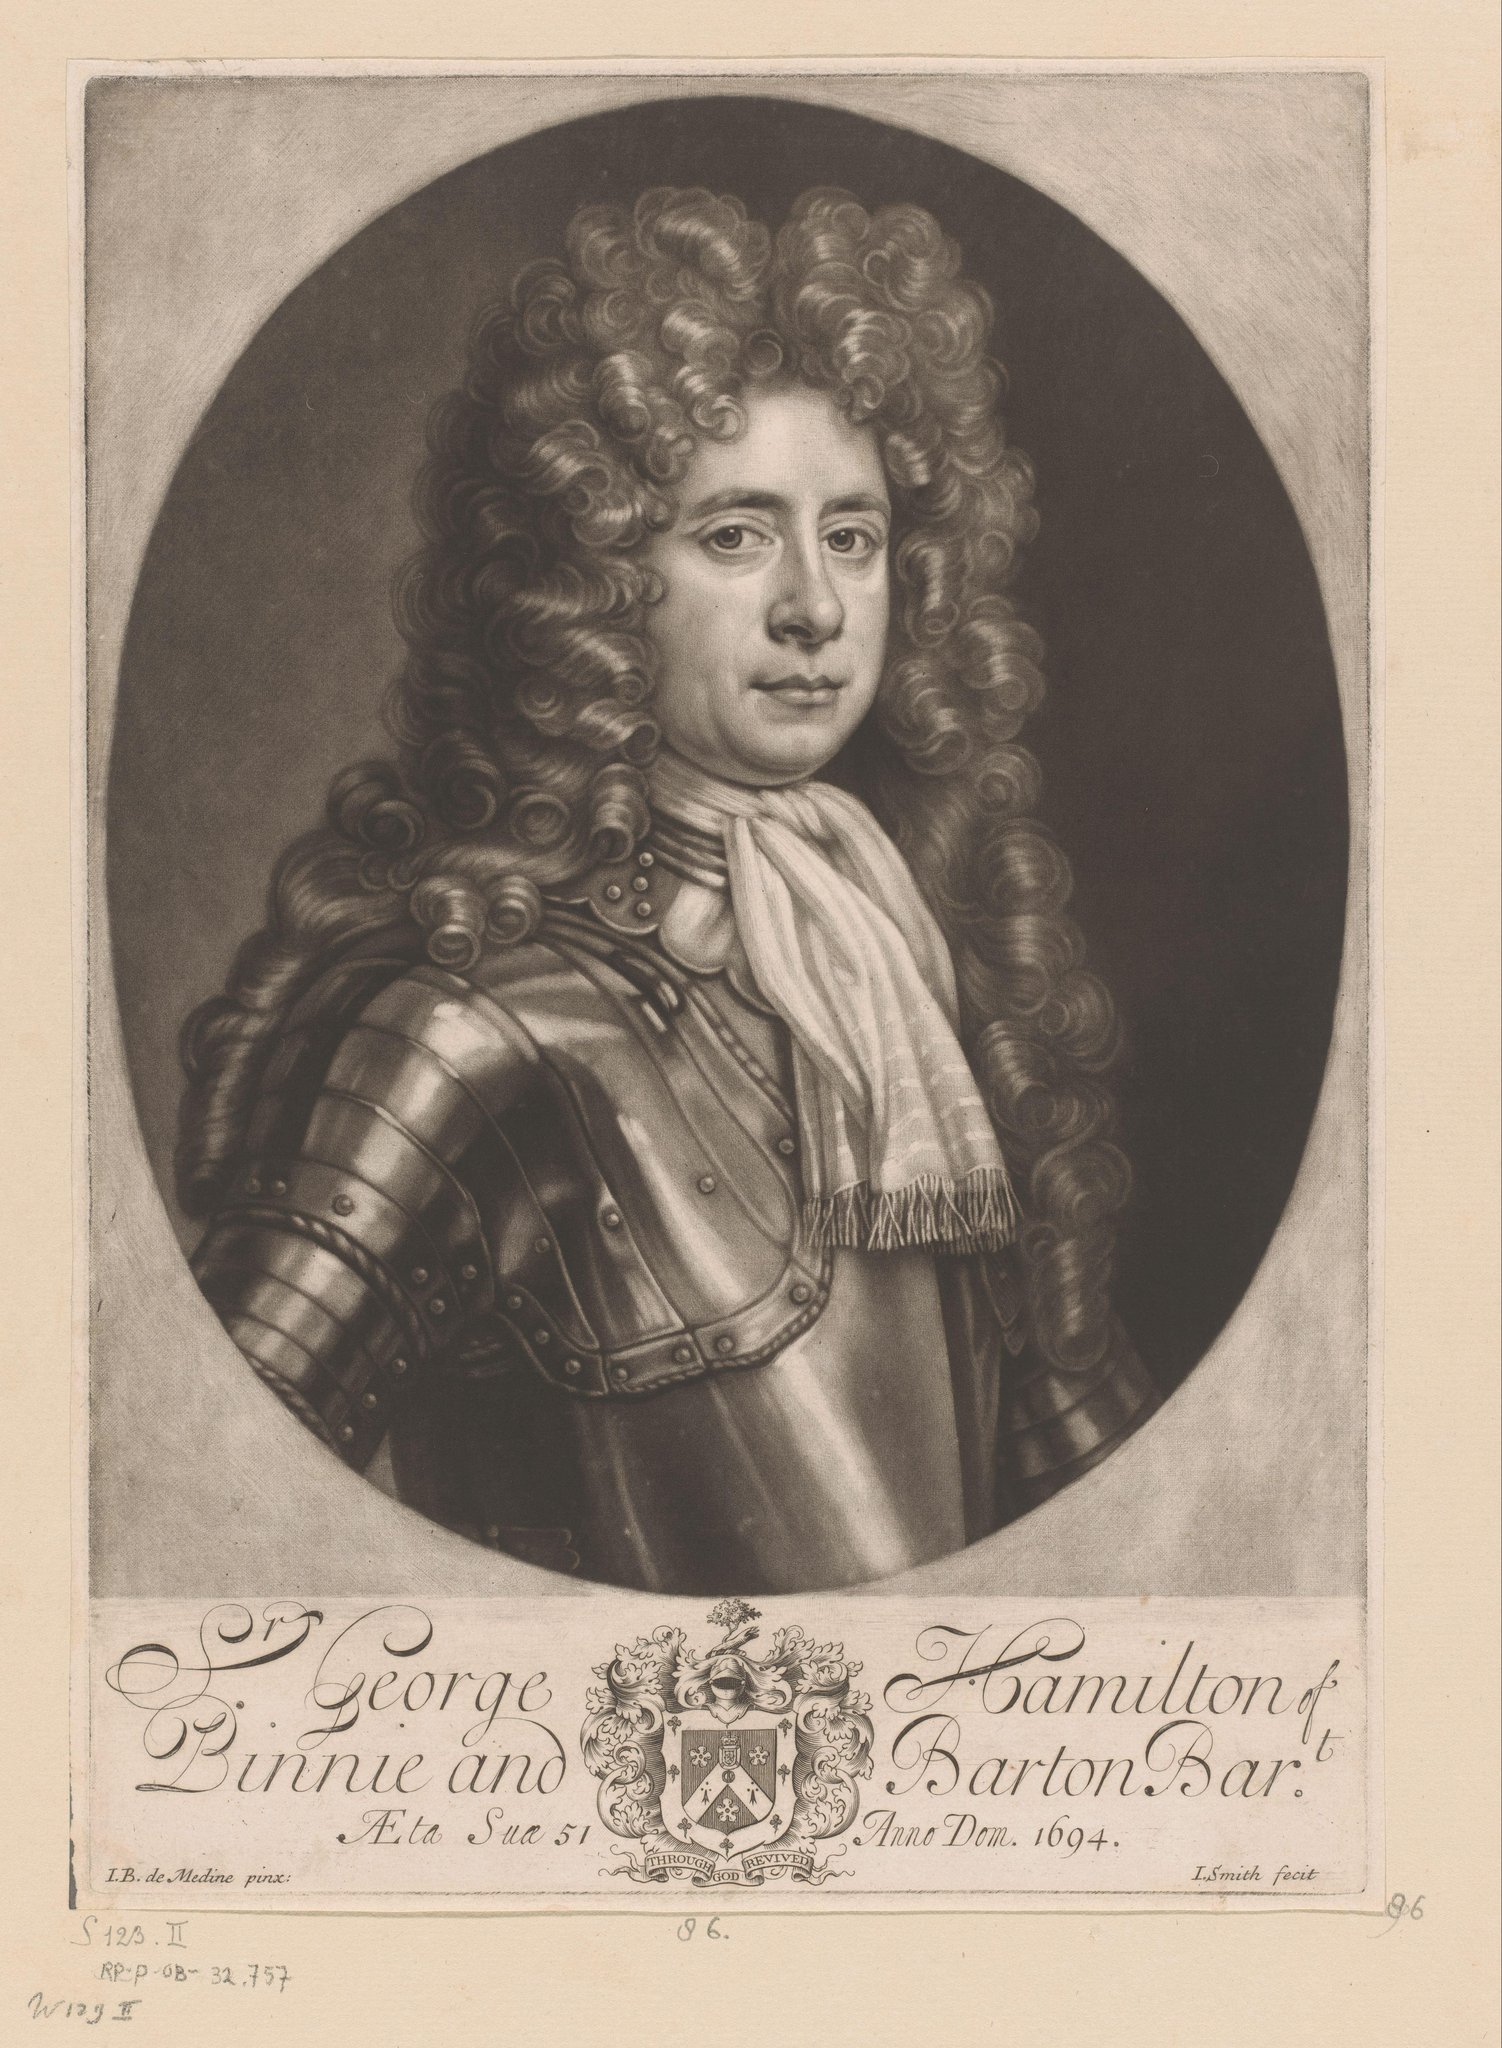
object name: print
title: Portret van George Hamilton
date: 1694-1742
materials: paper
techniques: mezzotint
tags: historical persons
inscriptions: collector's mark: Lugt 240